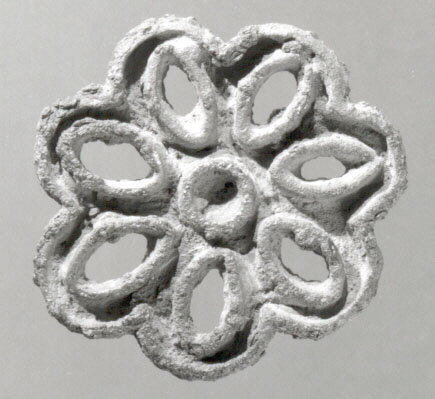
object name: stamp seal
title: Compartmented stamp seal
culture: bactria-margiana archaeological complex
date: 2333-1668 BCE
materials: copper alloy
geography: bactria-margiana